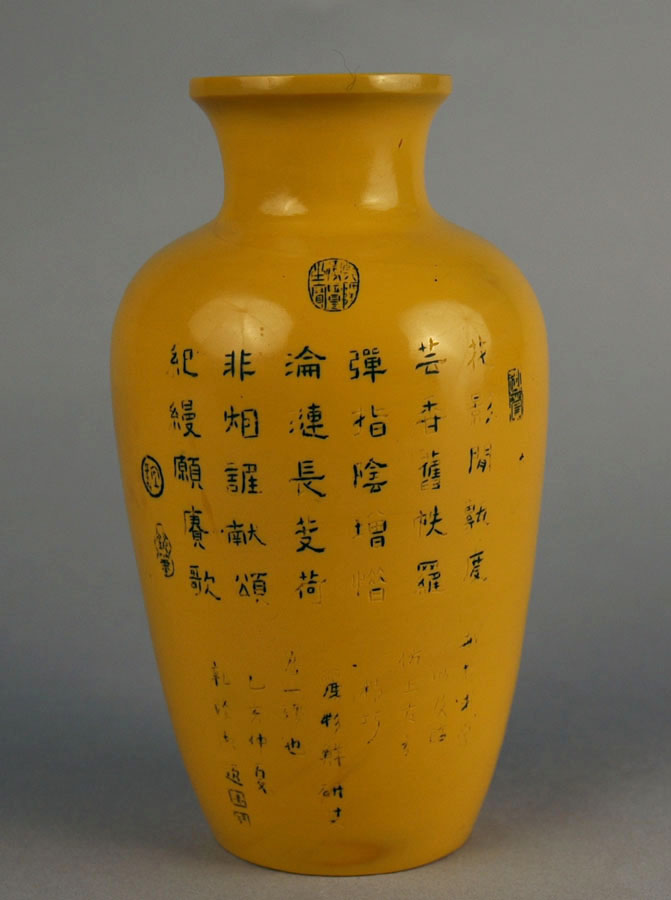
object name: vase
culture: chinese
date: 1644-1911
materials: glass